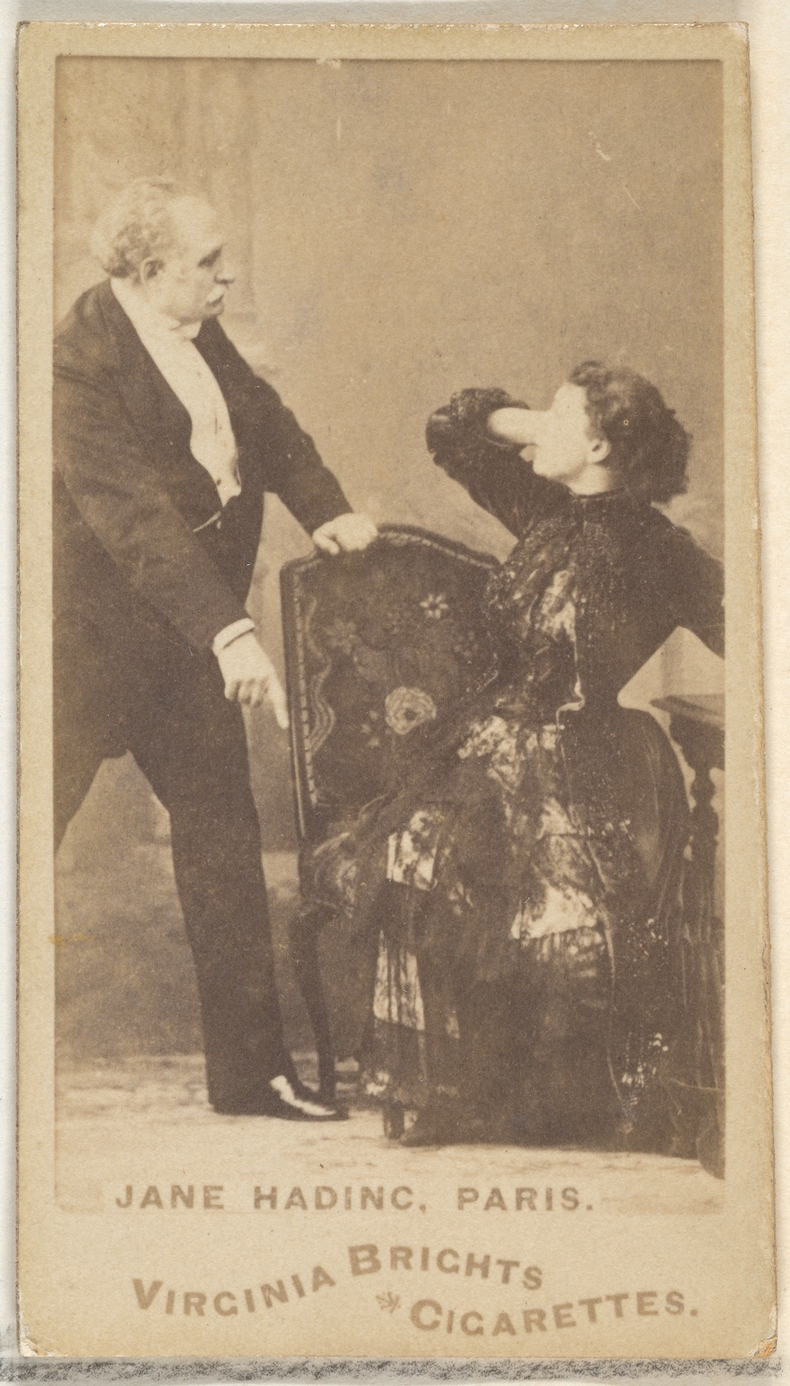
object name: photograph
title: Jane Hading, Paris, from the Actors and Actresses series (N45, Type 1) for Virginia Brights Cigarettes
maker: allen & ginter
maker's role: publisher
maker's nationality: american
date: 1888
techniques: albumen silver print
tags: men,portraits,women,actresses